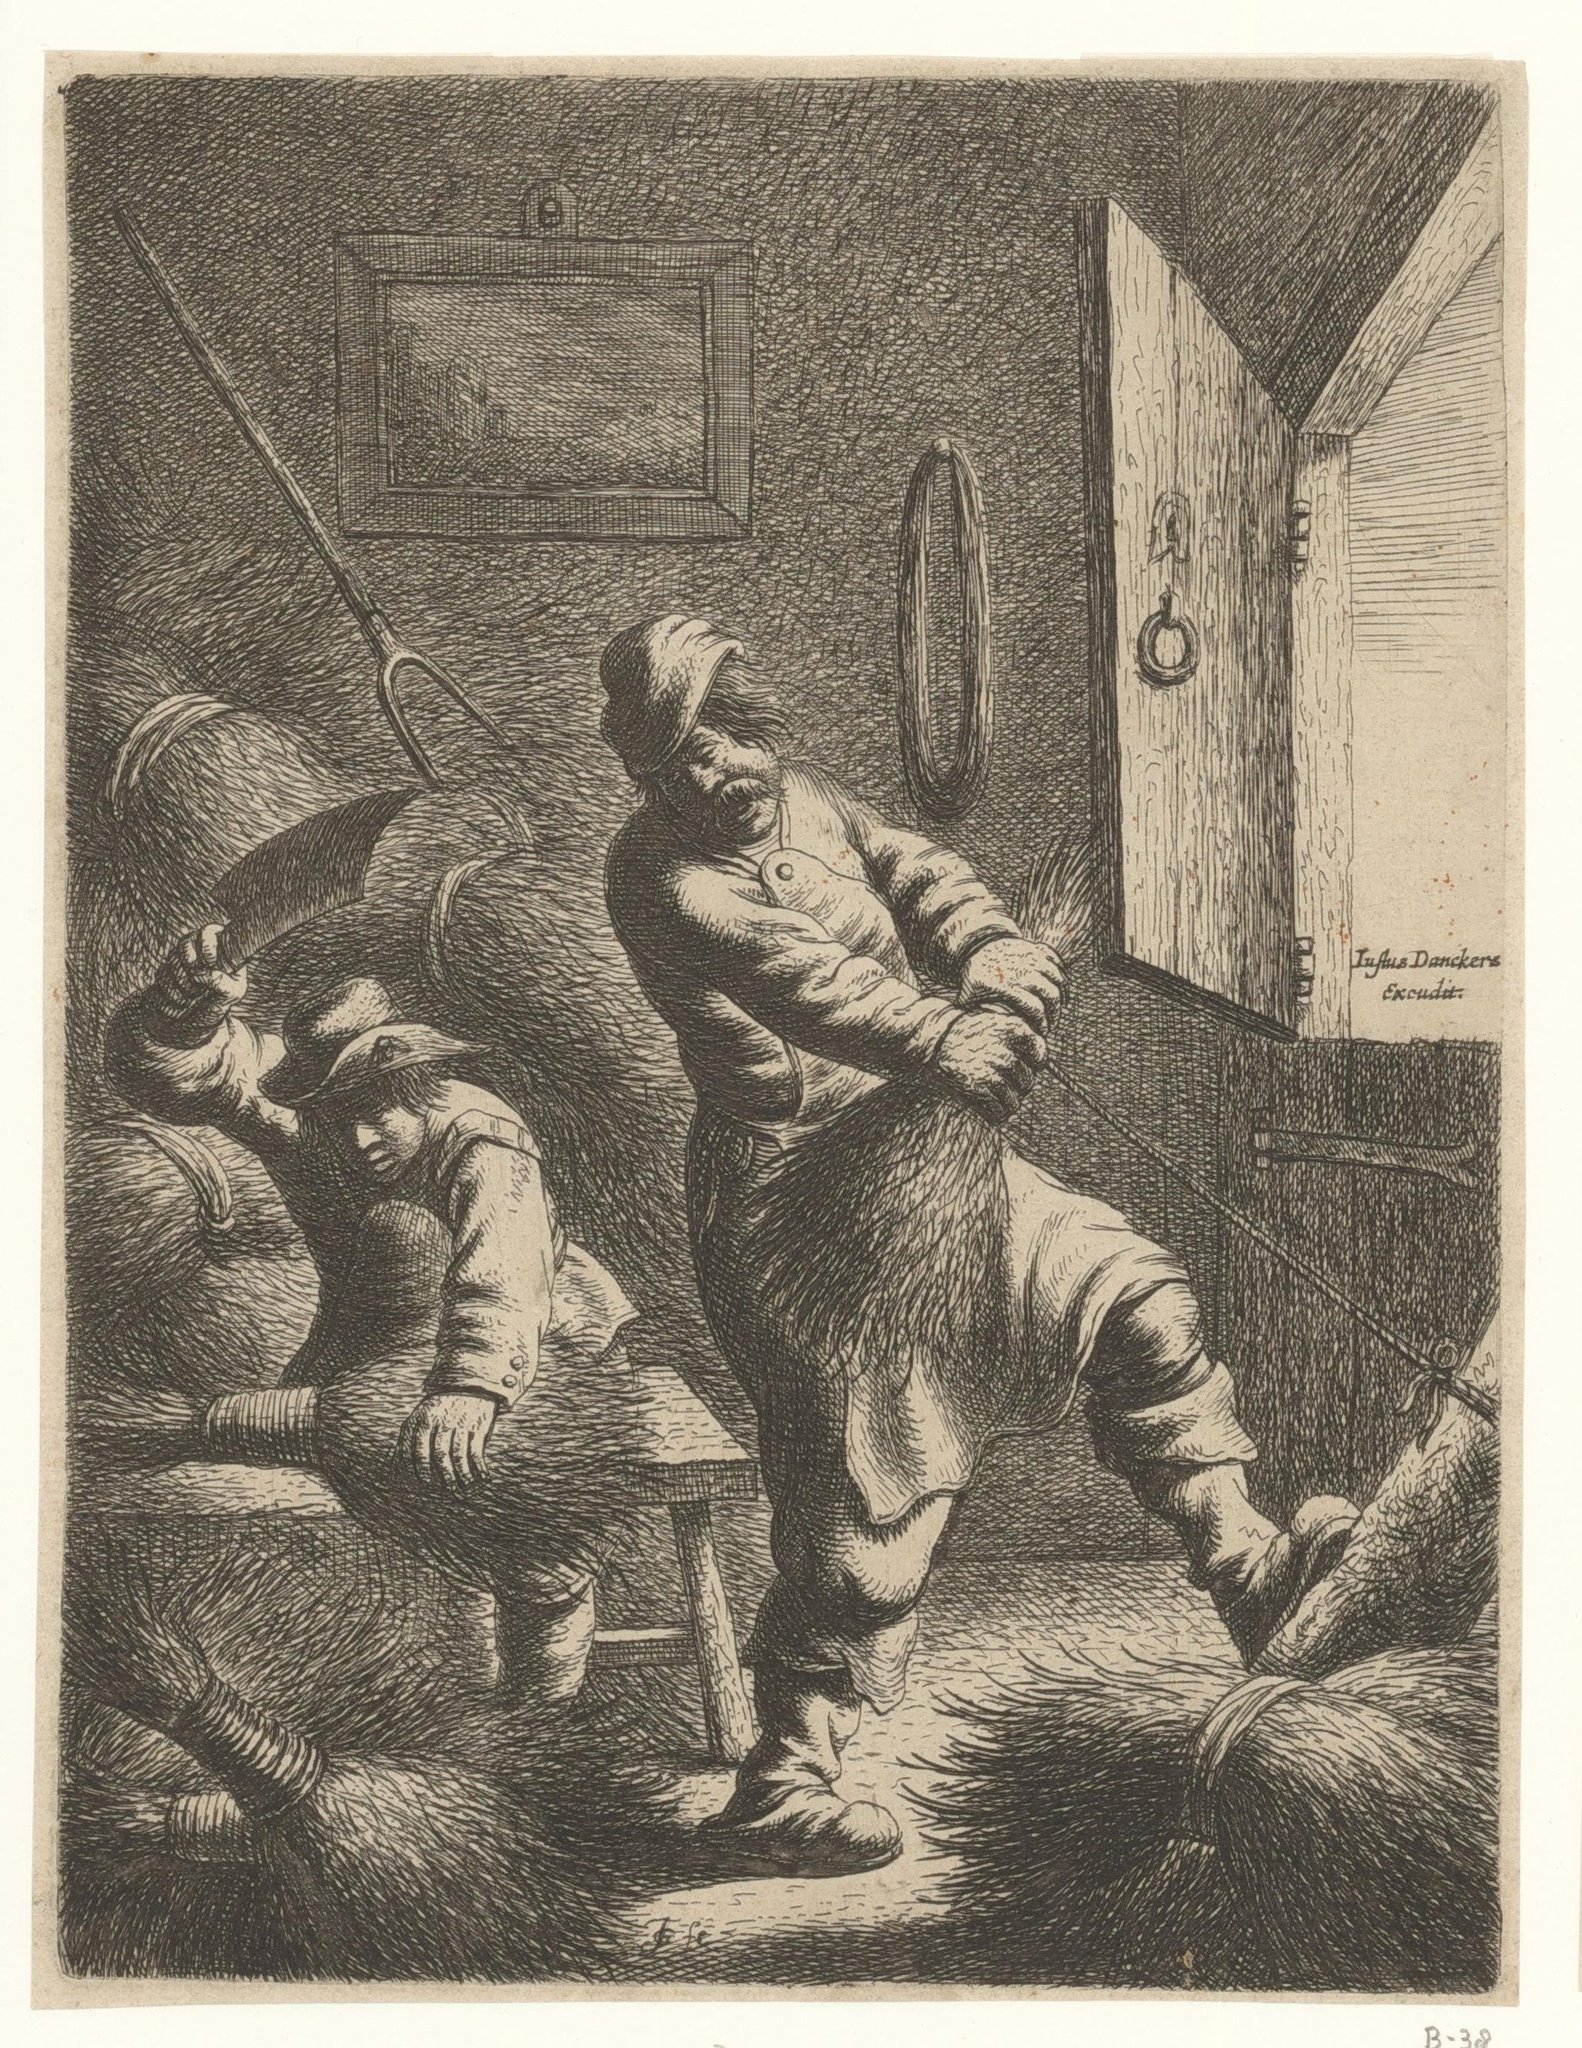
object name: print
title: Bezembinder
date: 1635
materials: paper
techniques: etching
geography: amsterdam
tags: craft-production, skilled handiwork, handicrafts, craftsman at work, divided door, upper part opened, (household) utensils and implements (with name)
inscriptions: stamp, collector's mark: Lugt 1641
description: Twee bezemmakers aan het werk in een werkplaats met een geopende bovendeur. Onderwerpsrubrieken binnen de Atlas Zeden en Gewoonten: Handel, Nijverheid en Verkeer, Beroep en bedrijf, Complete suites.